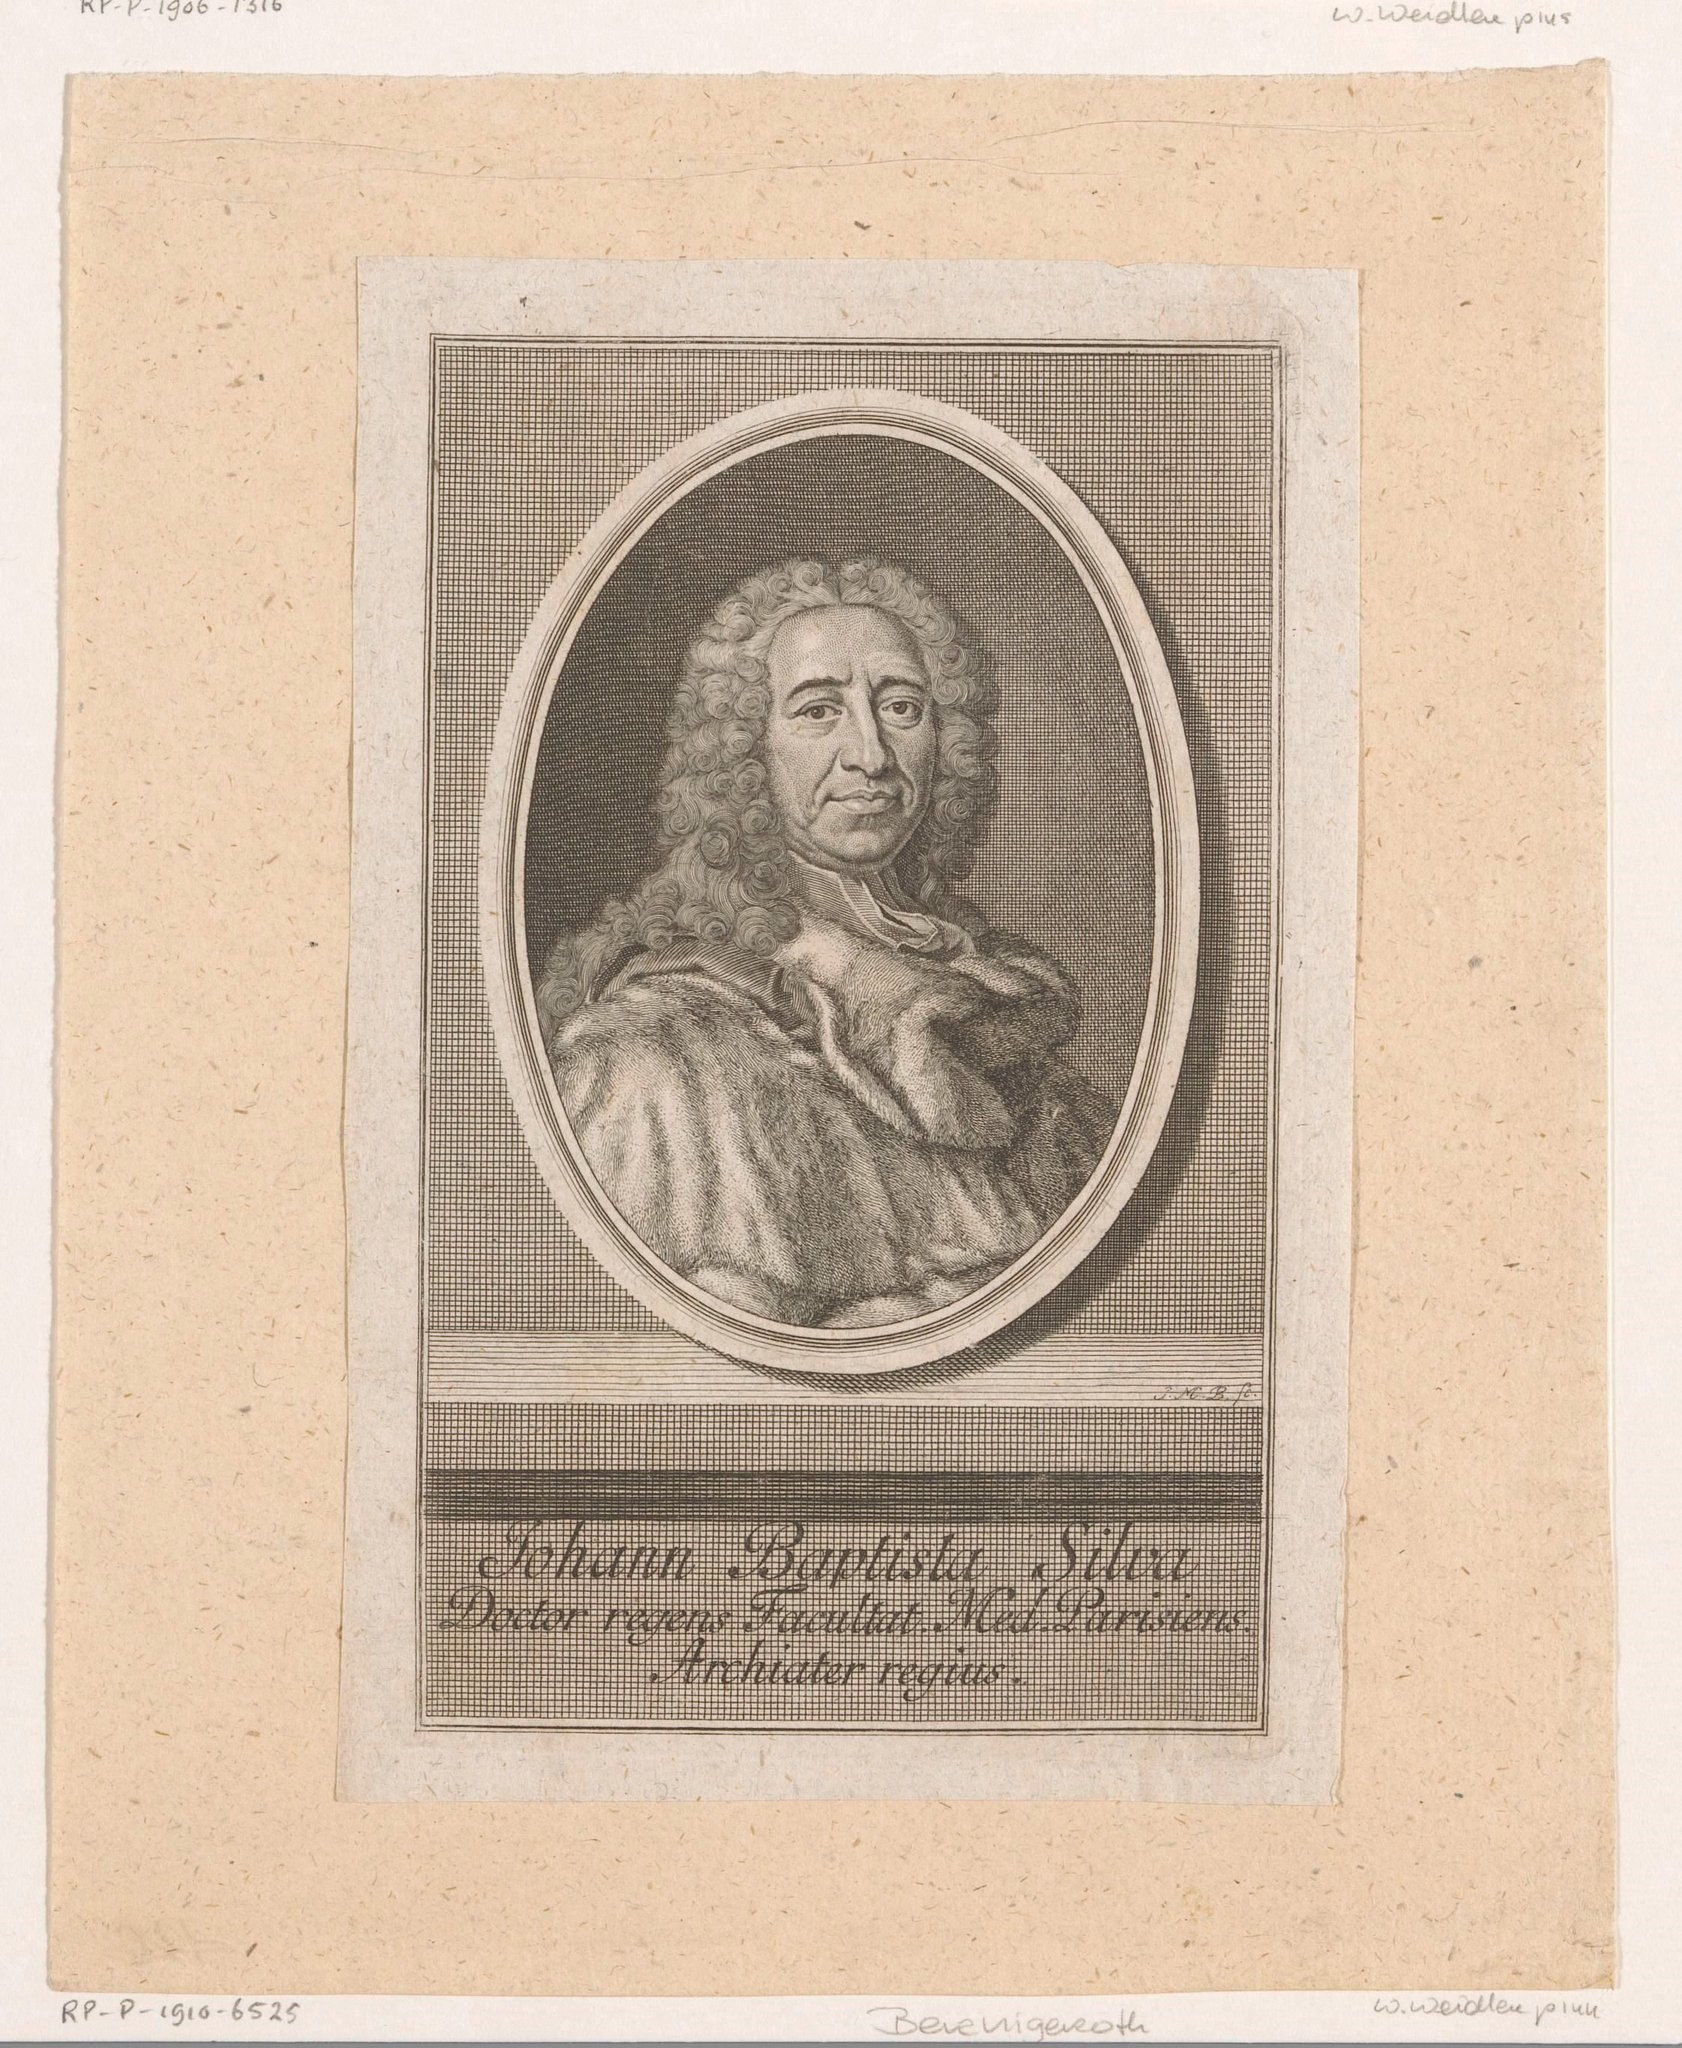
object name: print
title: Portret van Jean-Baptiste Silva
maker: johann martin bernigeroth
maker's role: print maker, publisher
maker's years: 1713-1767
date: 1744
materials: paper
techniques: engraving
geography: leipzig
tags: paris, historical persons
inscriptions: collector's mark: Lugt 2228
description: Prent ook gebruikt in: Zuverlässige Nachrichten von dem gegenwärtigen Zustande, Veränderung und Wachsthum der Wissenschaften. dl. 51. Leipzig: Johann Friedrich Gleditsch, 1744.